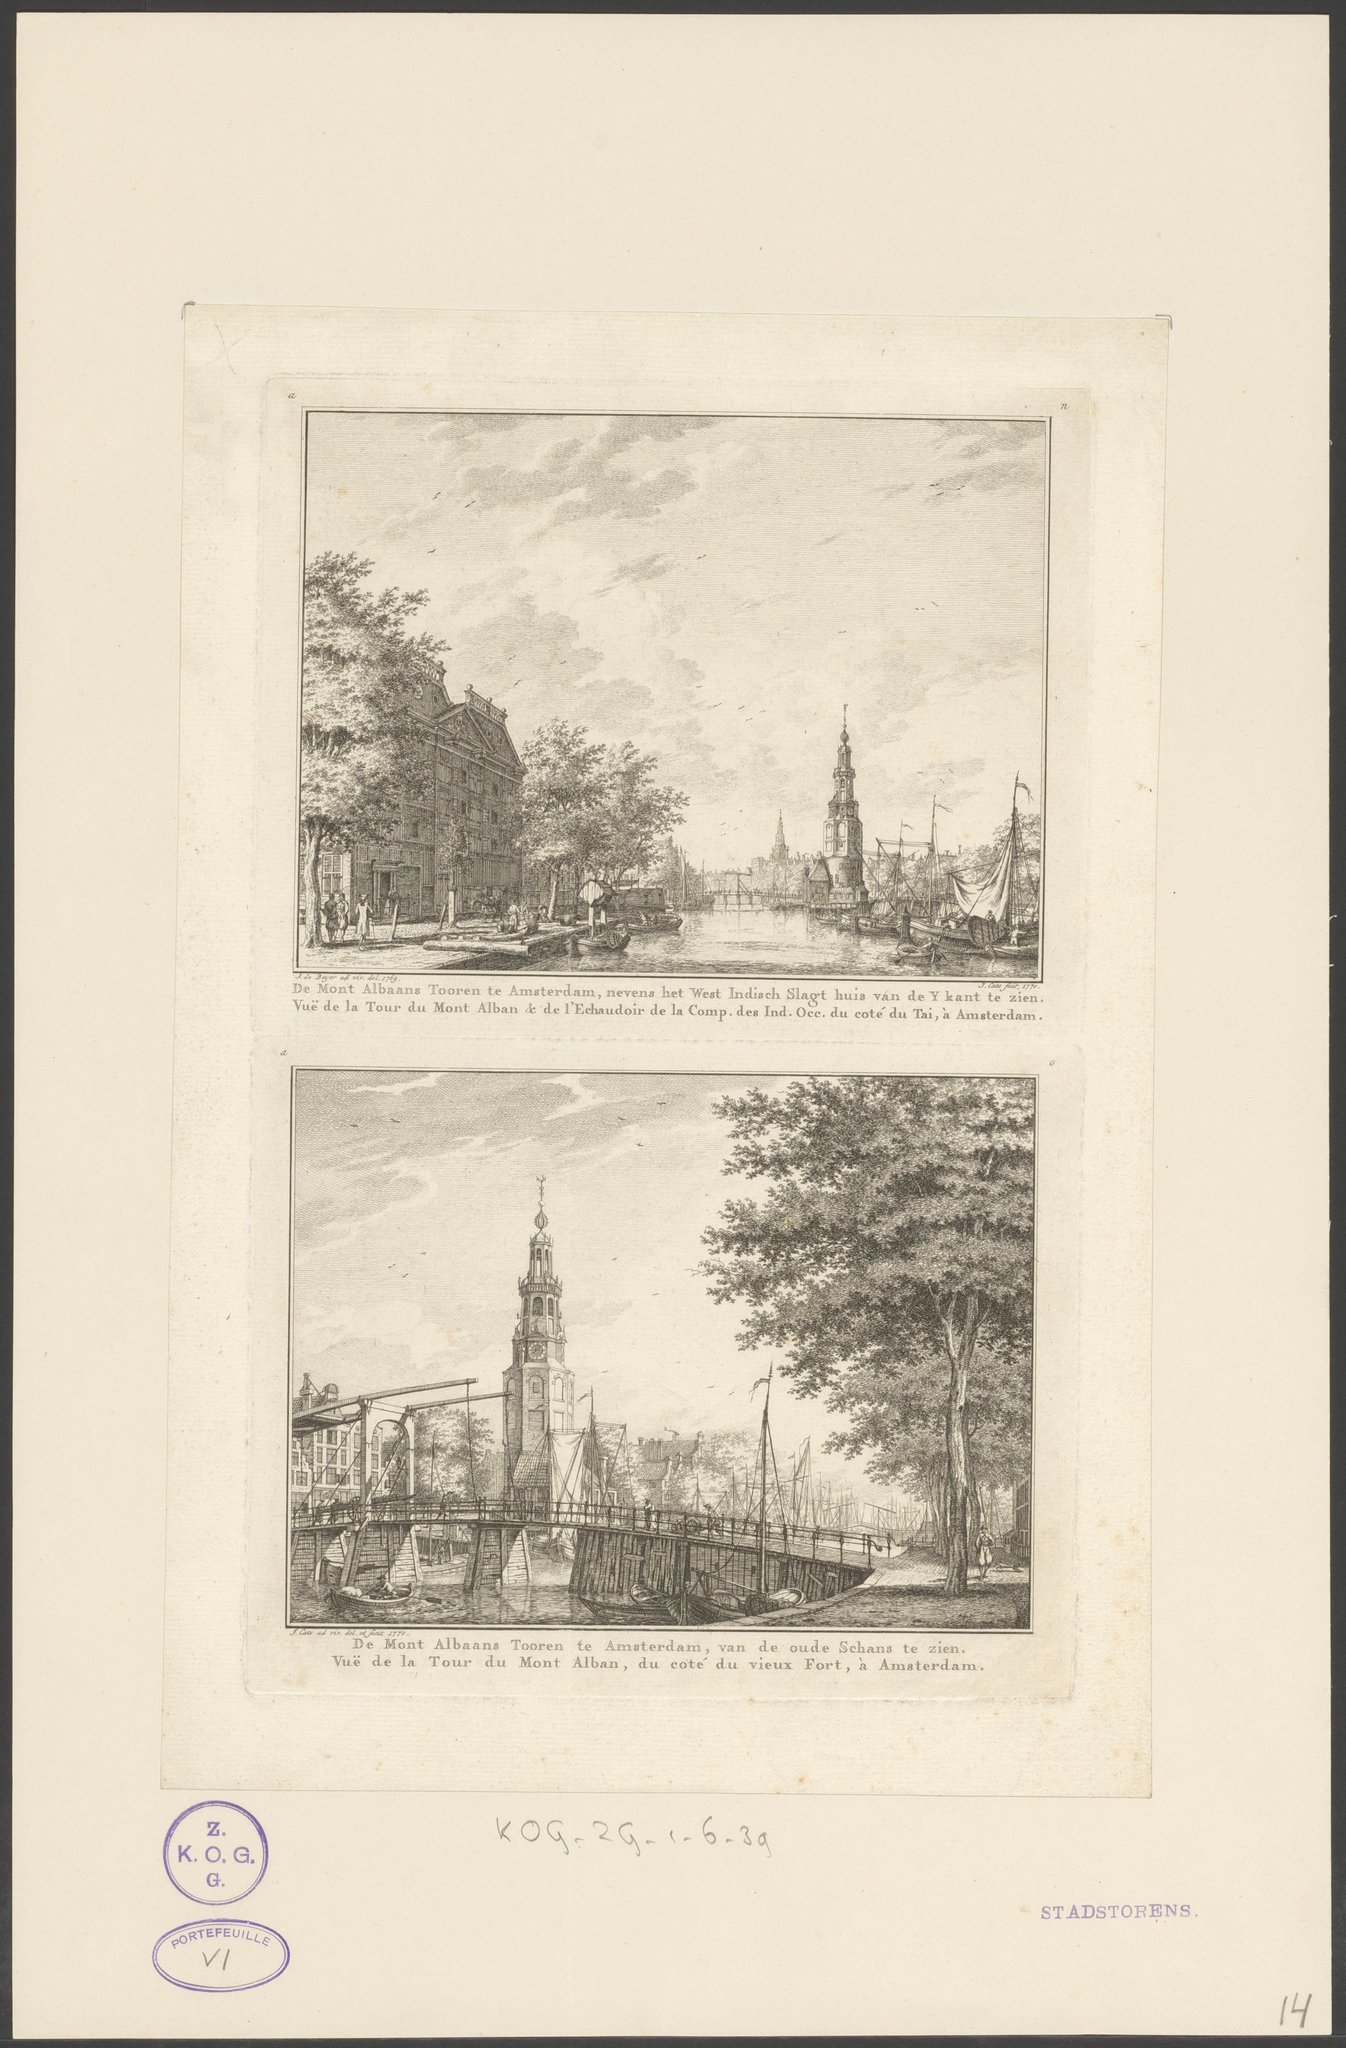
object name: book illustration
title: De Mont Albaans Tooren te Amsterdam, nevens het West Indisch Slagt huis van de Y kant te zien / Vuë de la Tour du Mont Alban & de l'Echaudoir de la Comp. des Ind. Occ. du coté du Tai, à Amsterdam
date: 1772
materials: paper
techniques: engraving, etching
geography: amsterdam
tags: harbour, towers ~ fortified city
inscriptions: collector's mark: Lugt 1641, stamp, stamp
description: Bovenaan bovenste plaat genummerd: a n. Bovenaan onderste plaat genummerd: a c. Onderwerpsrubrieken binnen de Atlas Zeden en Gewoonten: Krijgswezen, Stadstorens.